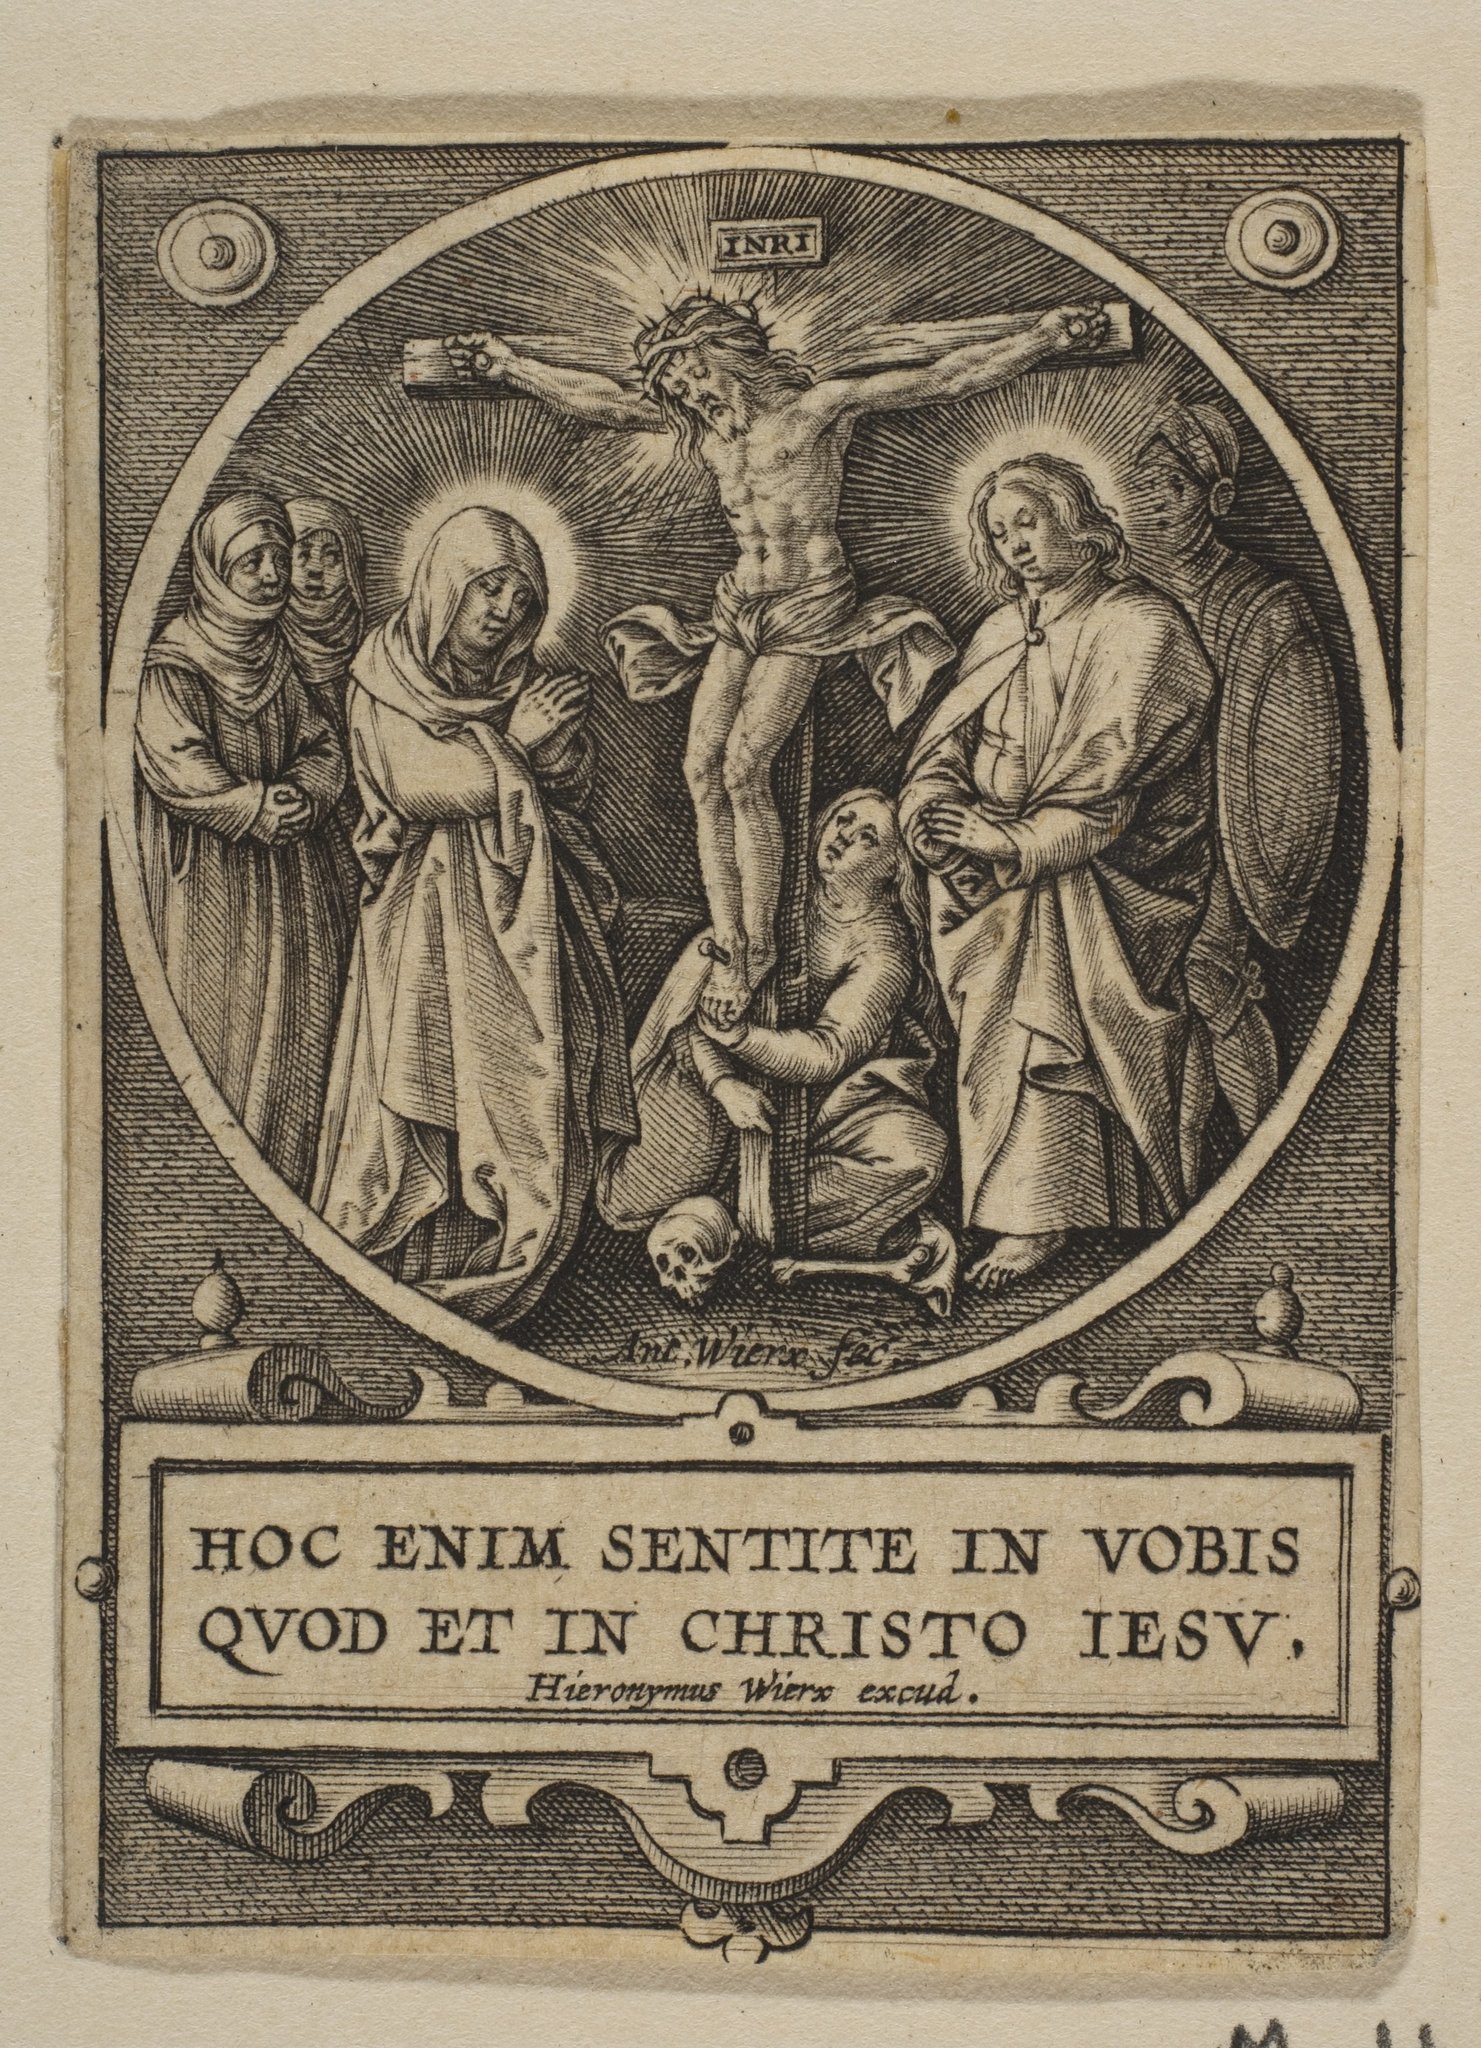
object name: print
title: The Crucifixion (Round) (reverse copy)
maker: hieronymus wierix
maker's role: artist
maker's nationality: netherlandish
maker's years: 1553-1619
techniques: engraving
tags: sadness,christ,mary magdalene,virgin mary,crucifixion